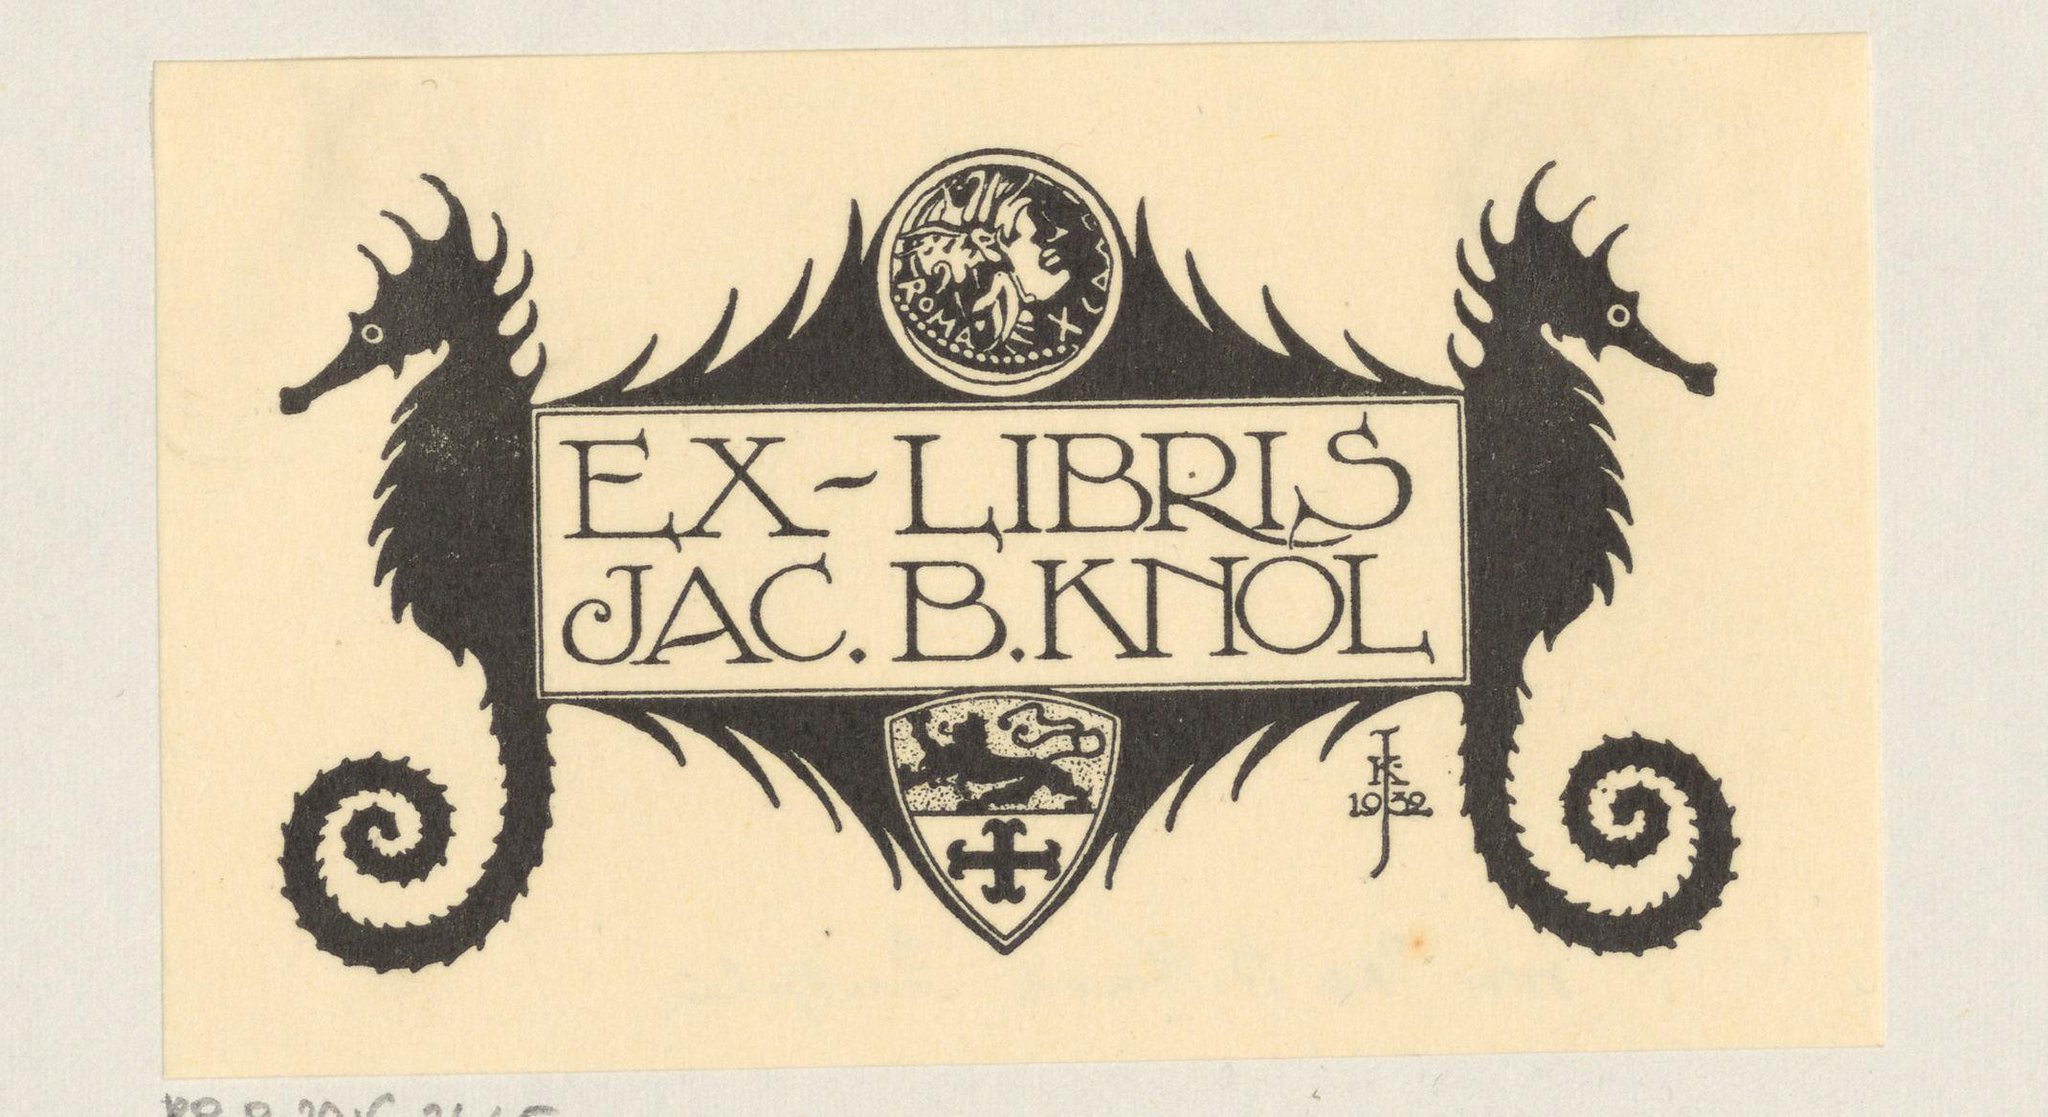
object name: bookplate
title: Ex libris van Jac. B. Knol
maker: jac. b. knol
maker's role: verzamelaar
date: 1932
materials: paper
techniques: printing block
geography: netherlands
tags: jac. b. knol, sea-horse, hippocamp, 'hippocampus', (horse/fish) (mythological hybrid monster), coin, armorial bearing, heraldry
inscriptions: date